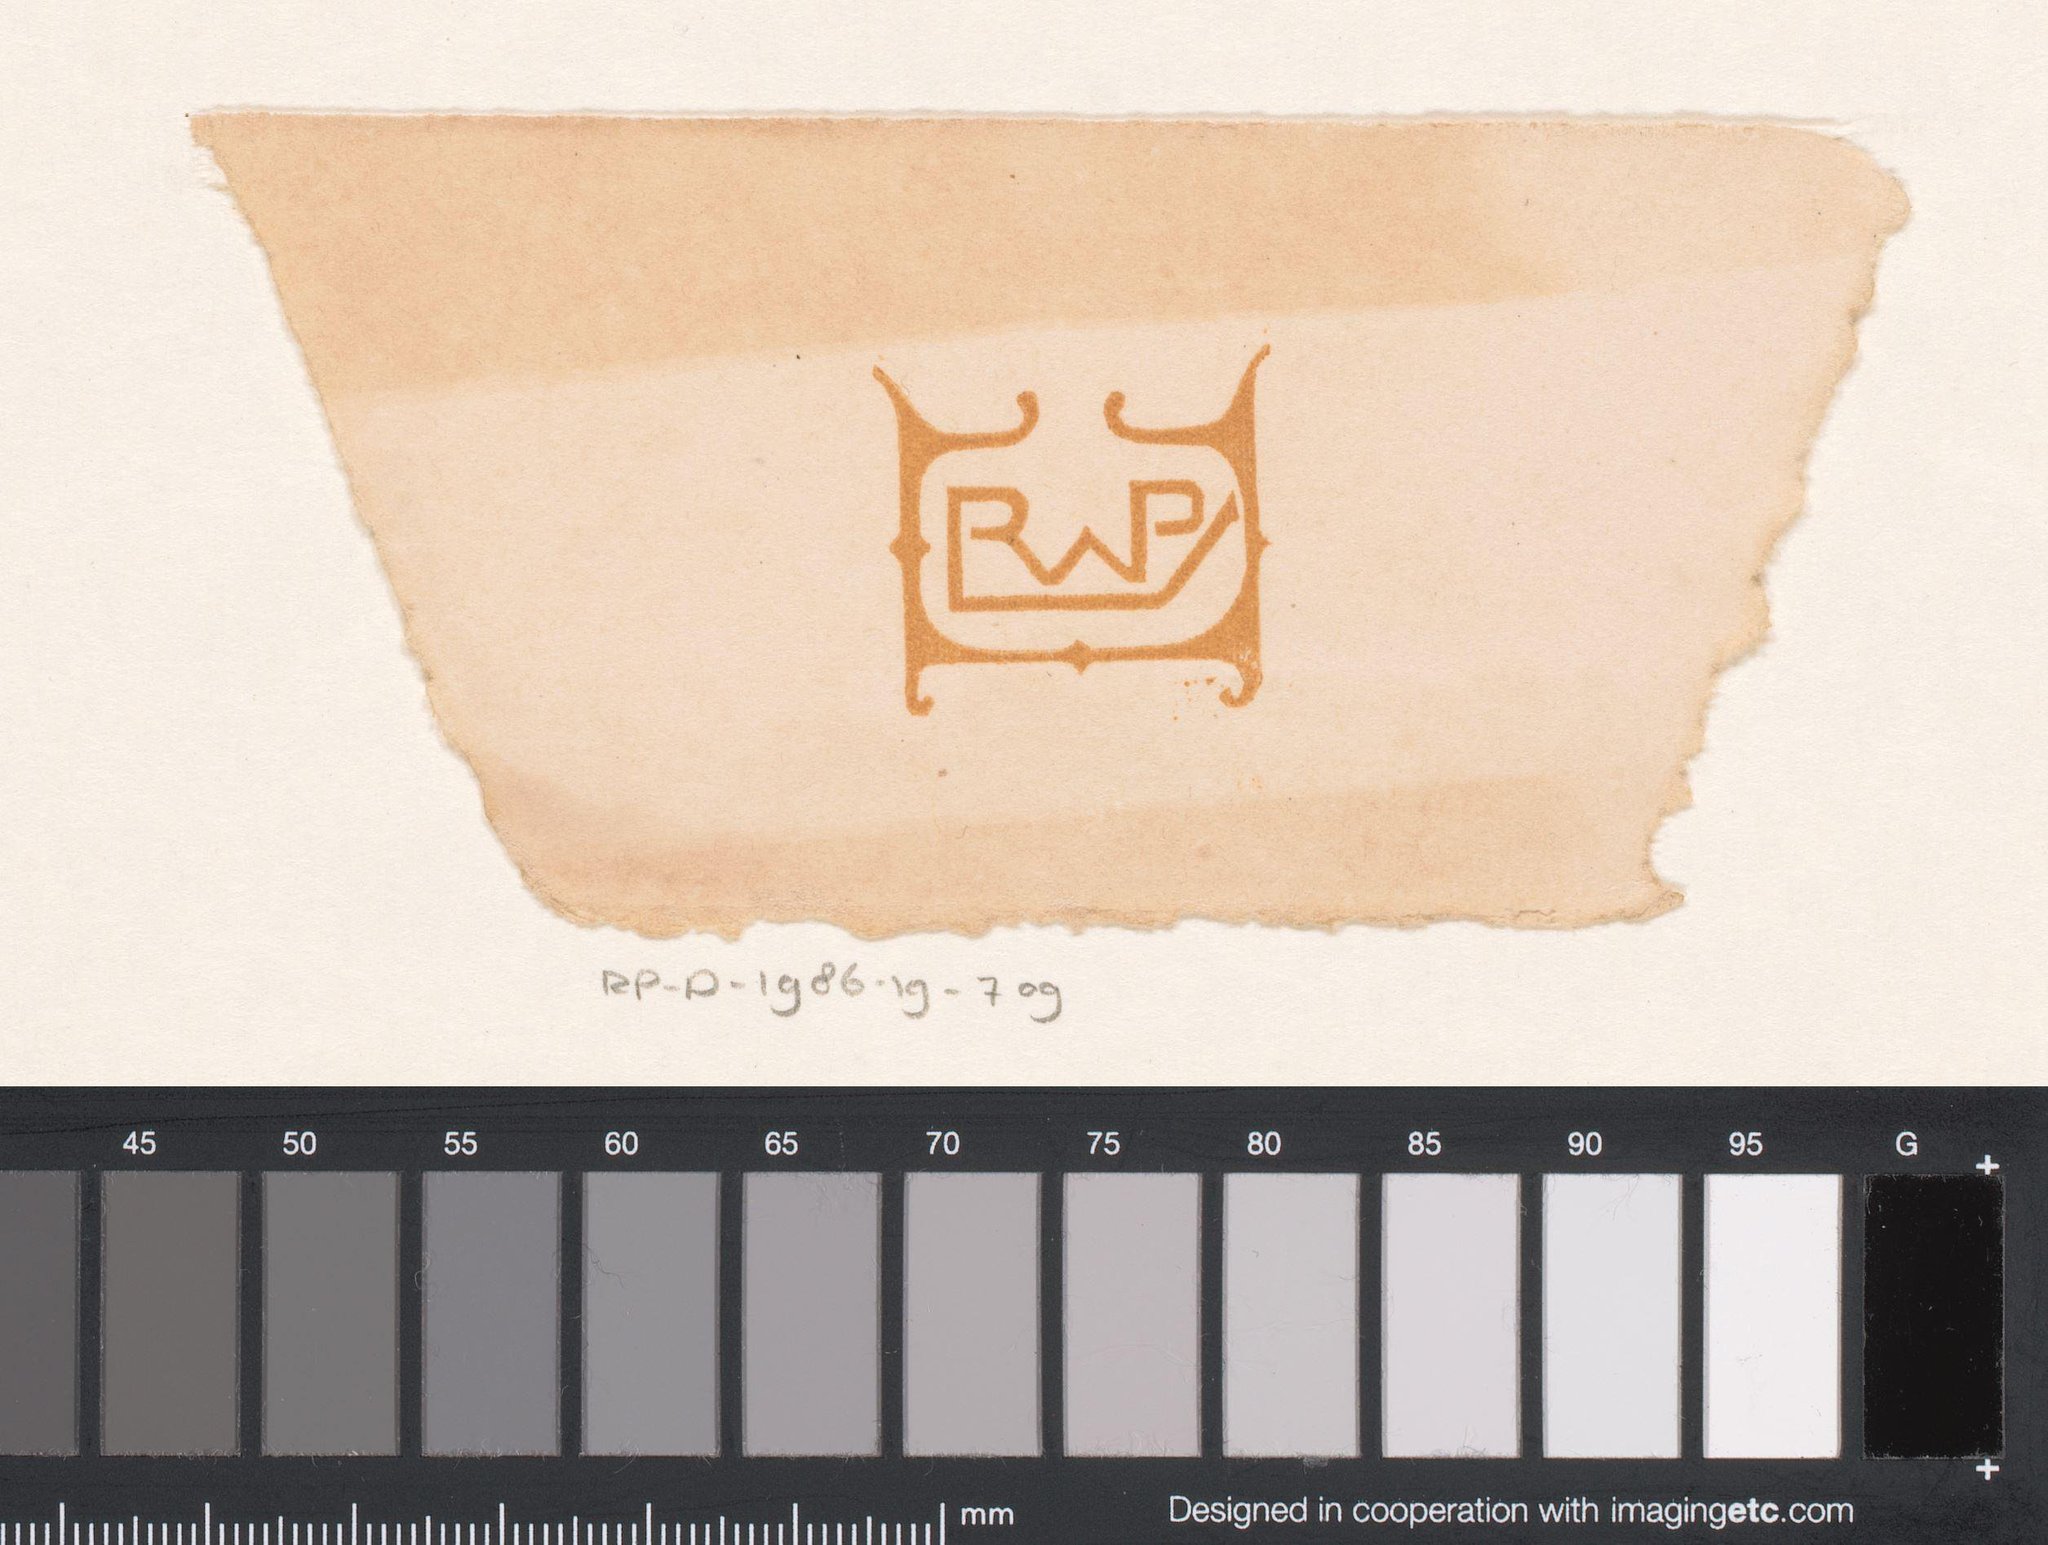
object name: photomechanical print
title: Vignet met monogram RWP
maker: reinier willem petrus de vries (1874-1953)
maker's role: draughtsman, print maker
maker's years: 1874-1953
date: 1884-1952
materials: paper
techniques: printing block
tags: print maker, draughtsman, reinier willem petrus de vries (1874-1953), magic mathematical figures; magic numbers, words, monograms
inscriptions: collector's mark: ‘R:MVS.’